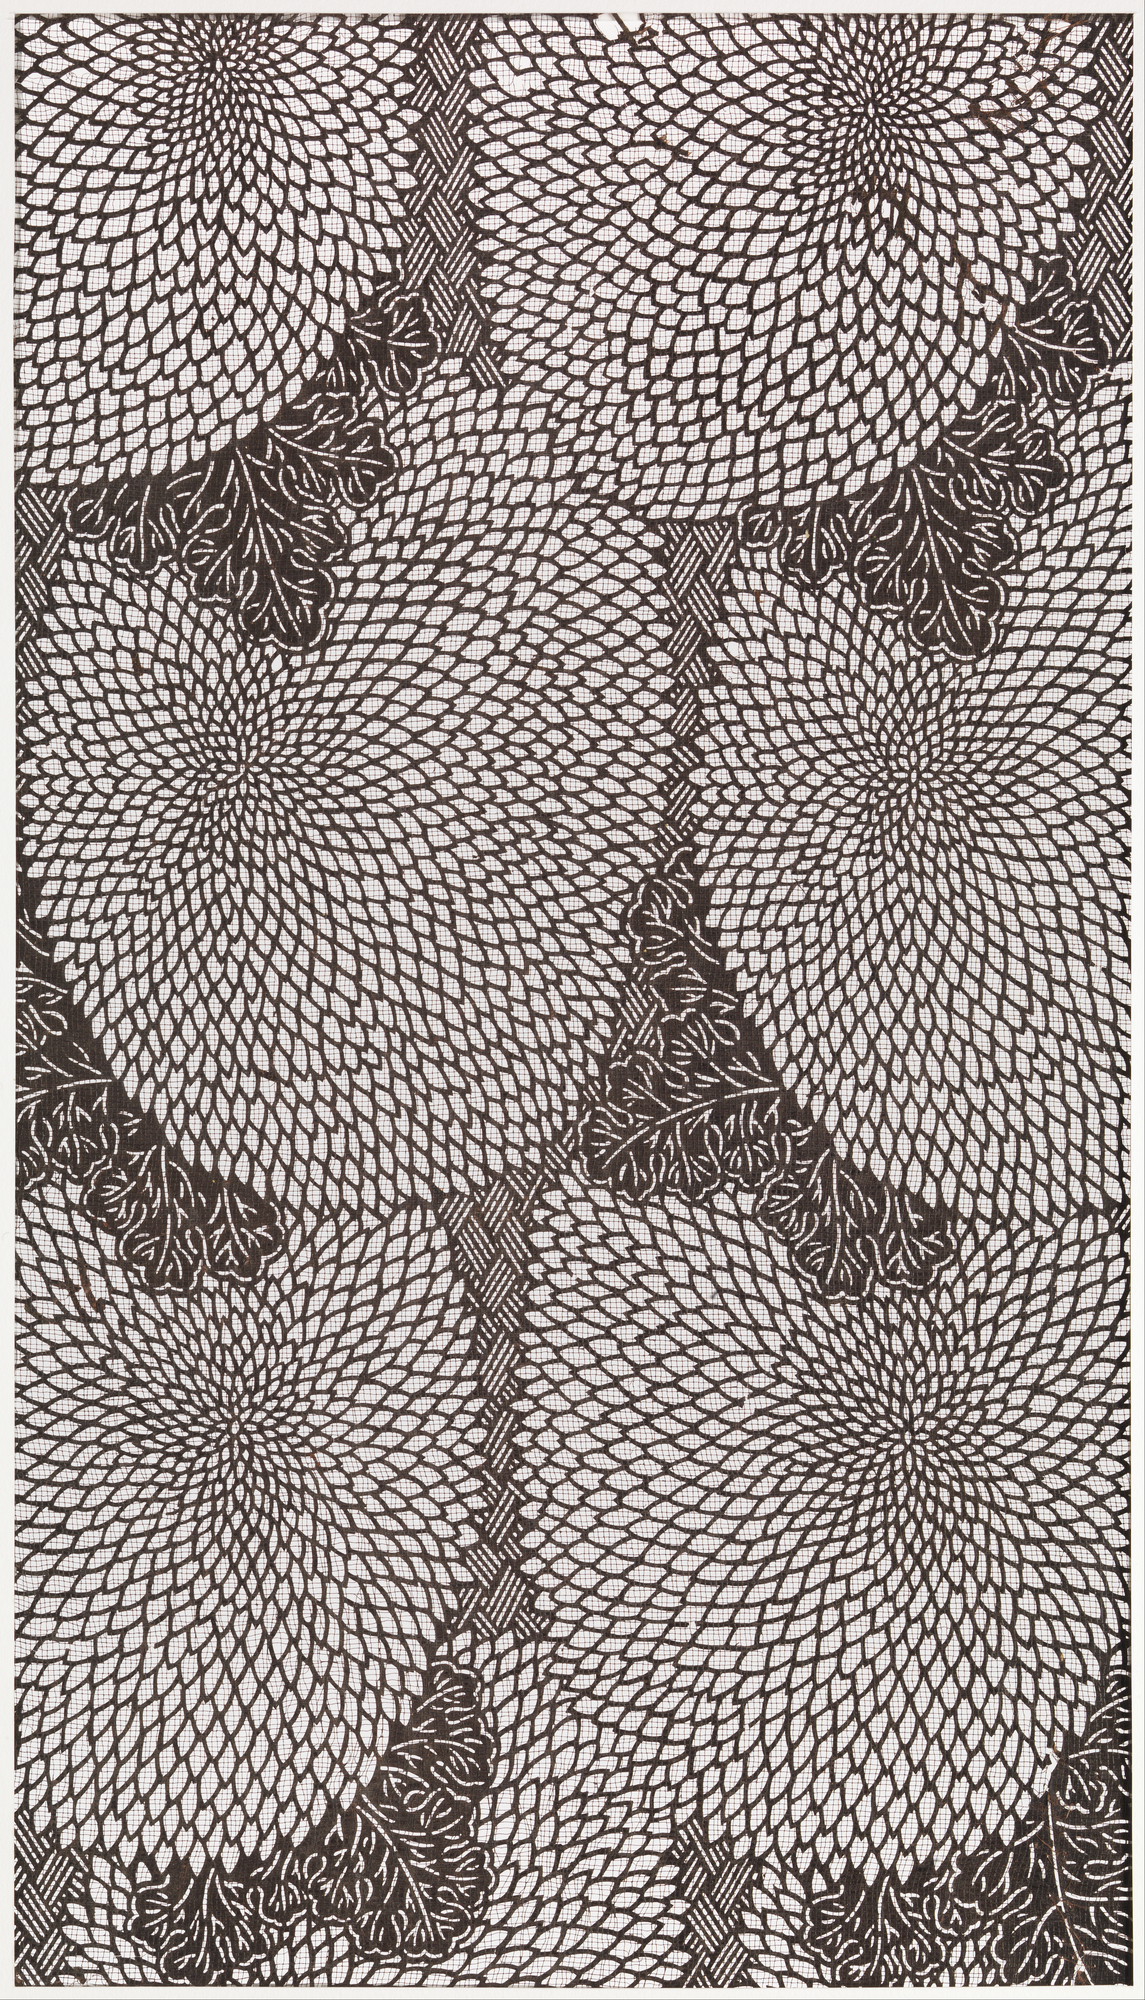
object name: stencil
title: Stencil with Chrysanthemums and Fence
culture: japanese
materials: paper, silk